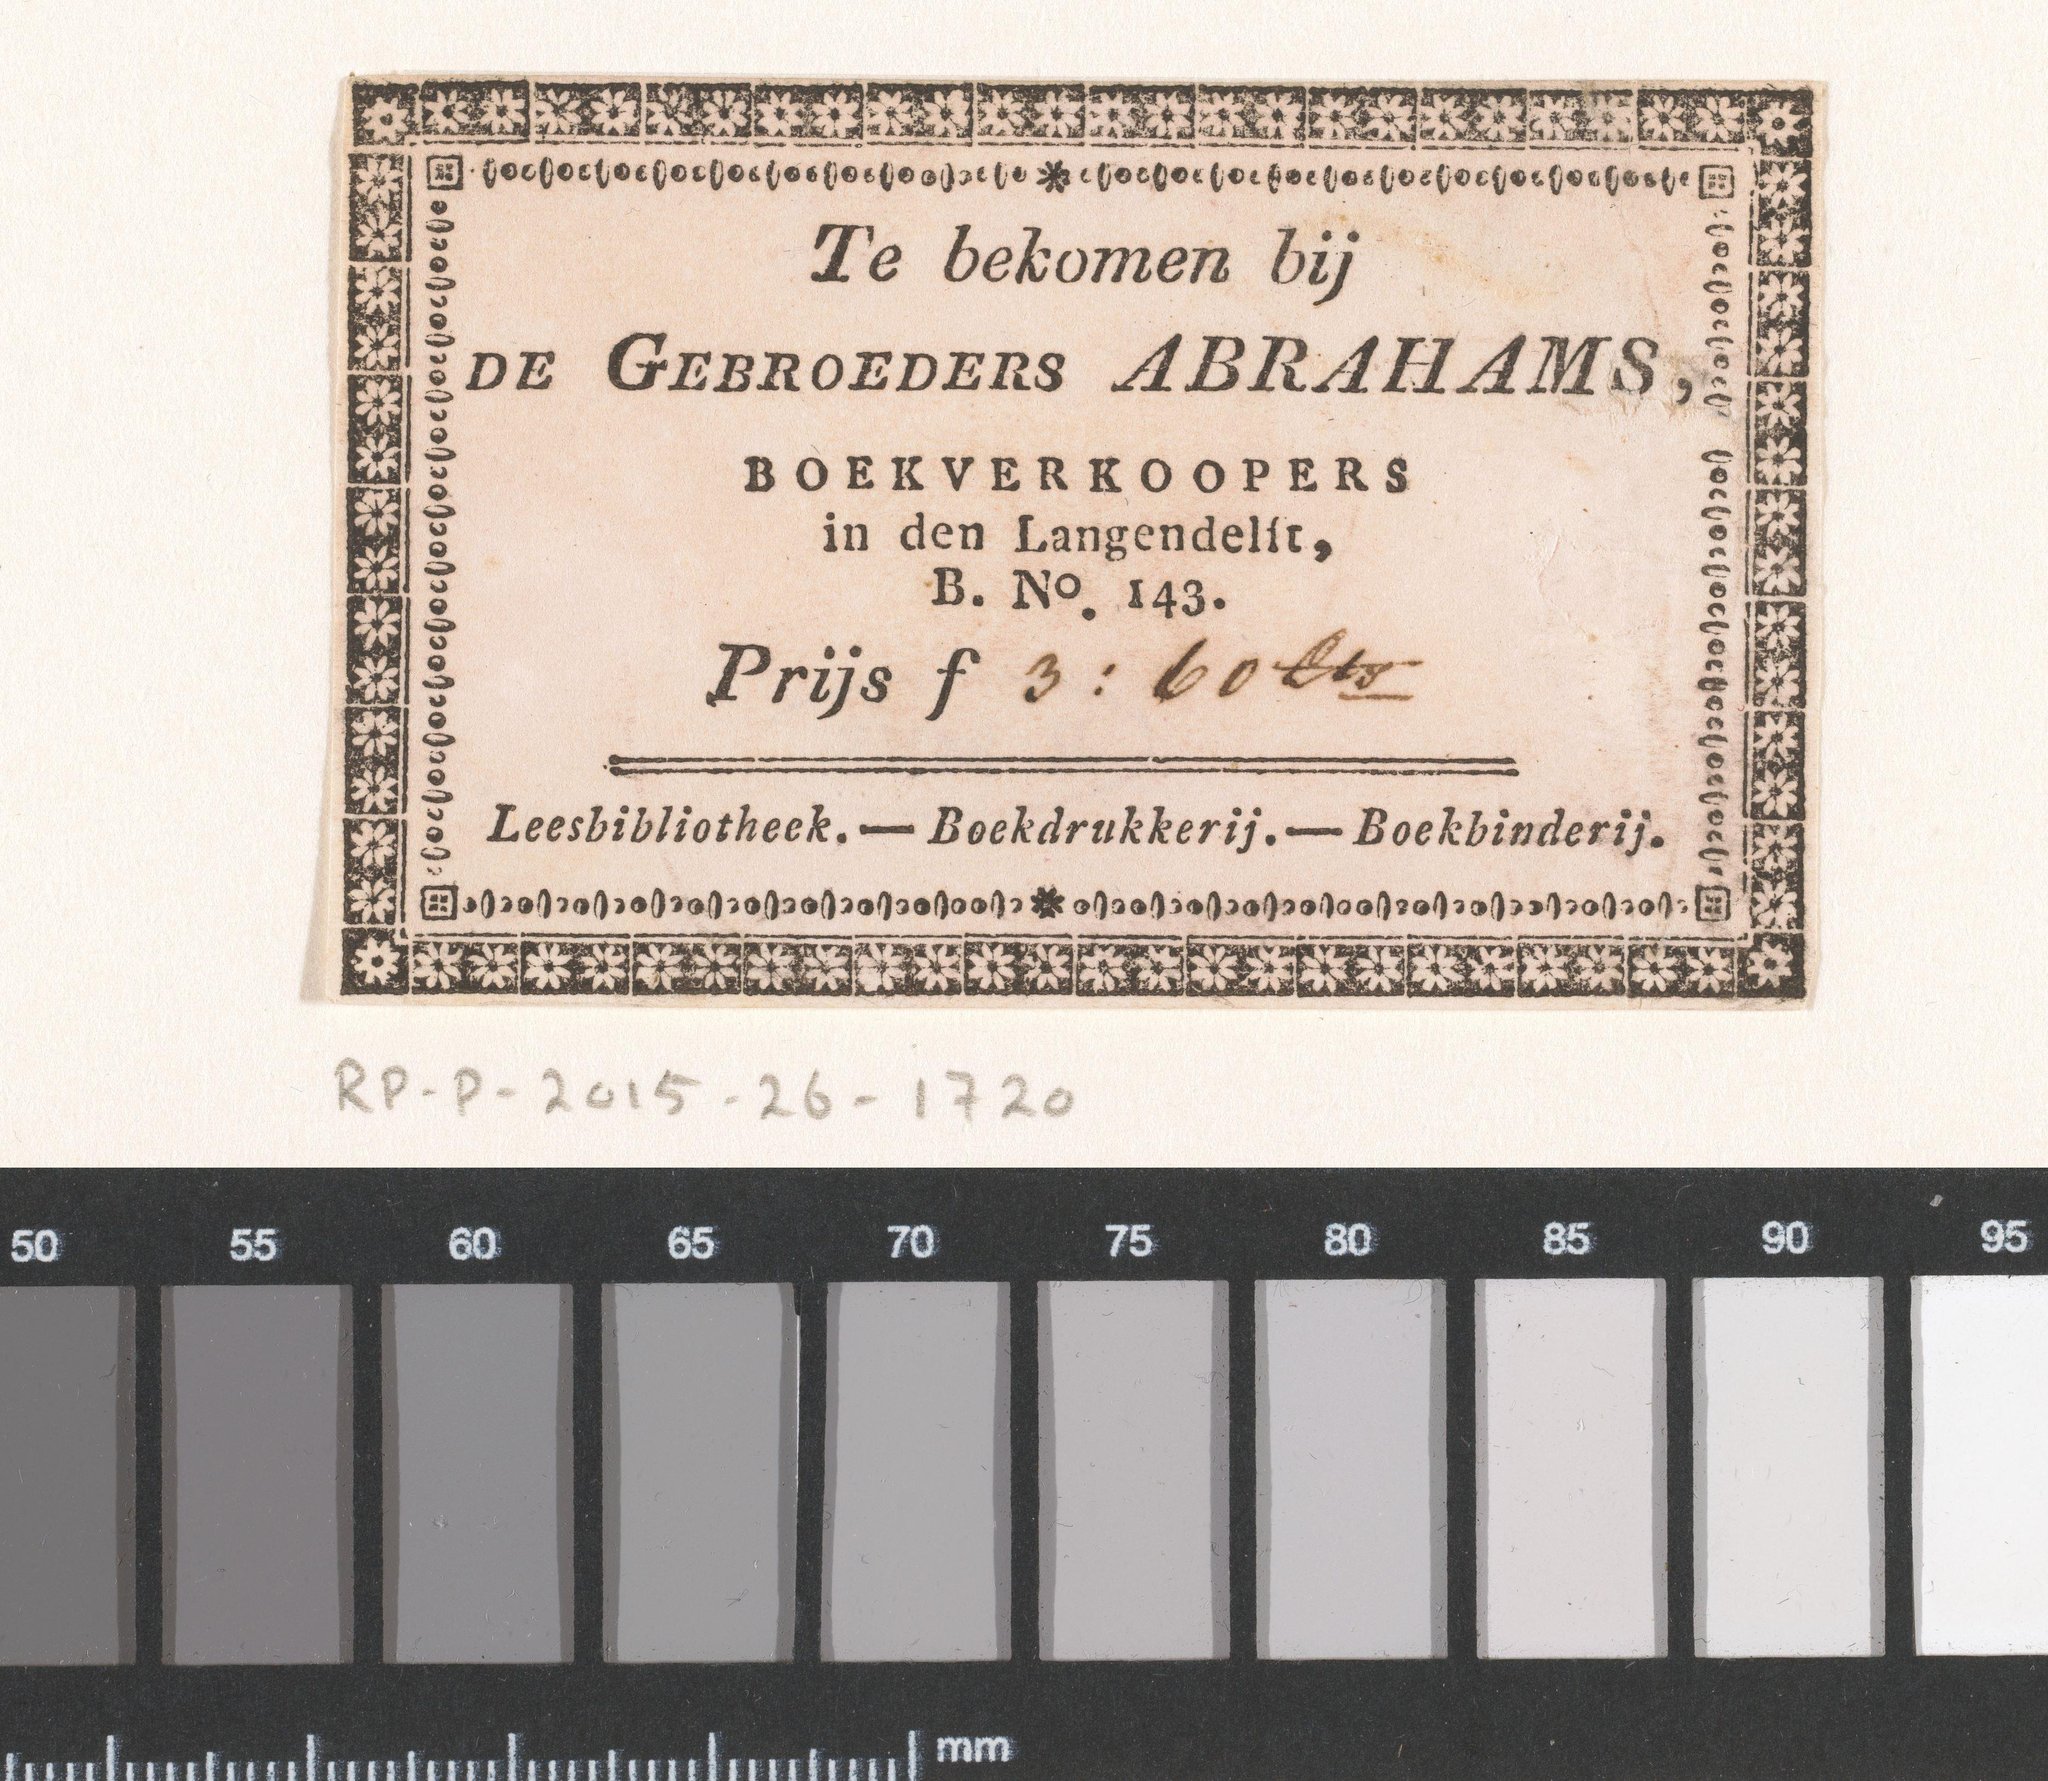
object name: print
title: Boekhandelsetiket van de Gebroeders Abrahams, boekverkopers te Middelburg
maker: Anonymous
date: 1814-1887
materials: paper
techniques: lithograph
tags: middelburg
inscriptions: annotation: ‘3: 60 cts.’, collector's mark: Lugt 2228